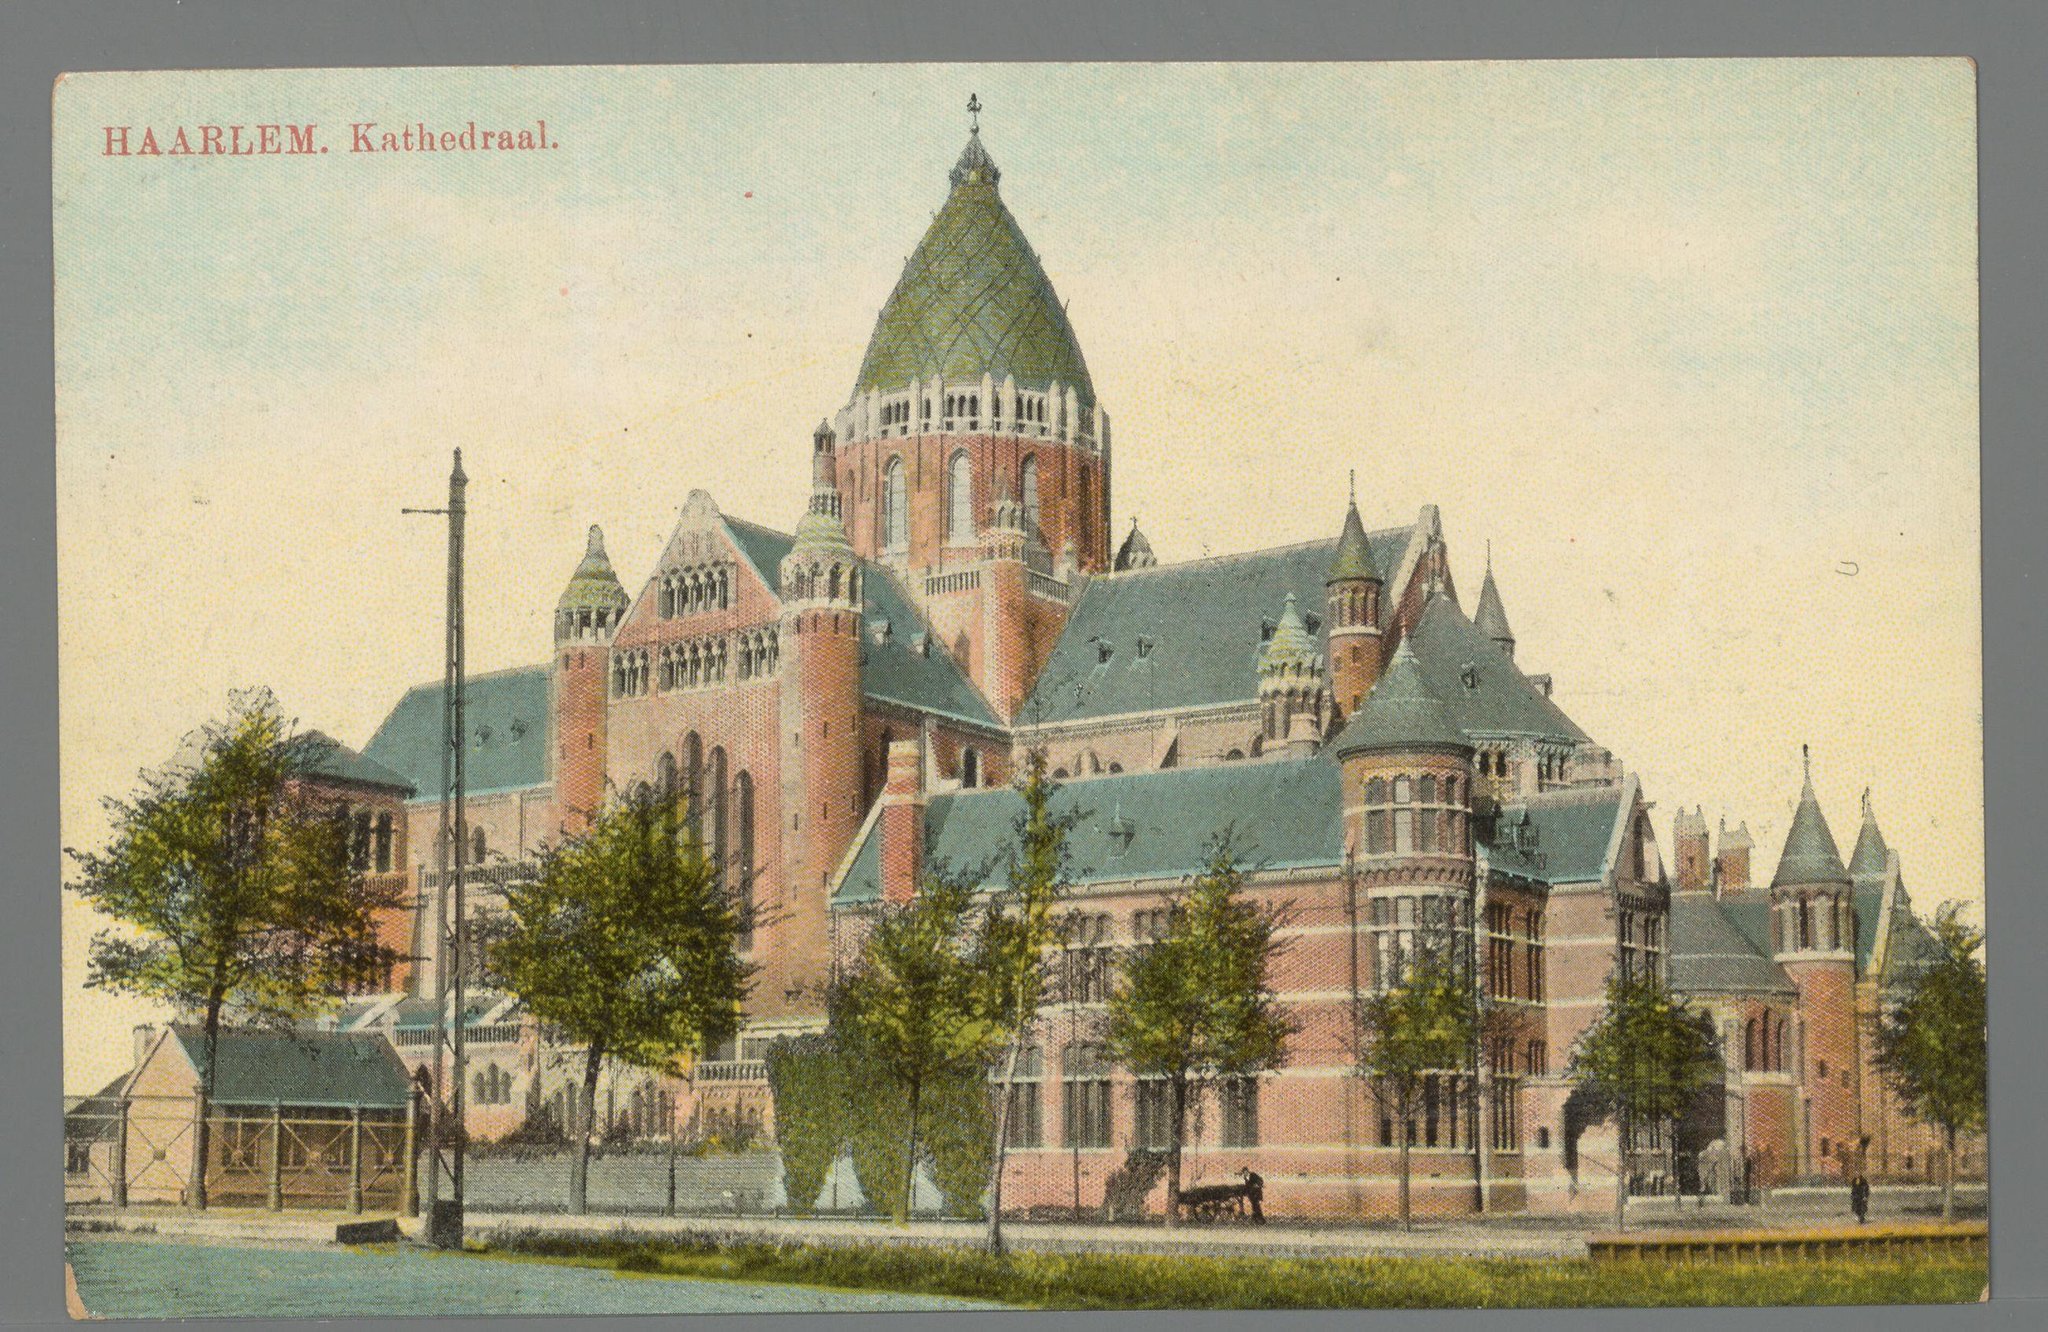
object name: photomechanical print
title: Haarlem. Kathedraal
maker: Anonymous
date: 1905-1930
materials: cardboard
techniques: lithograph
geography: haarlem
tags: church (exterior), haarlem